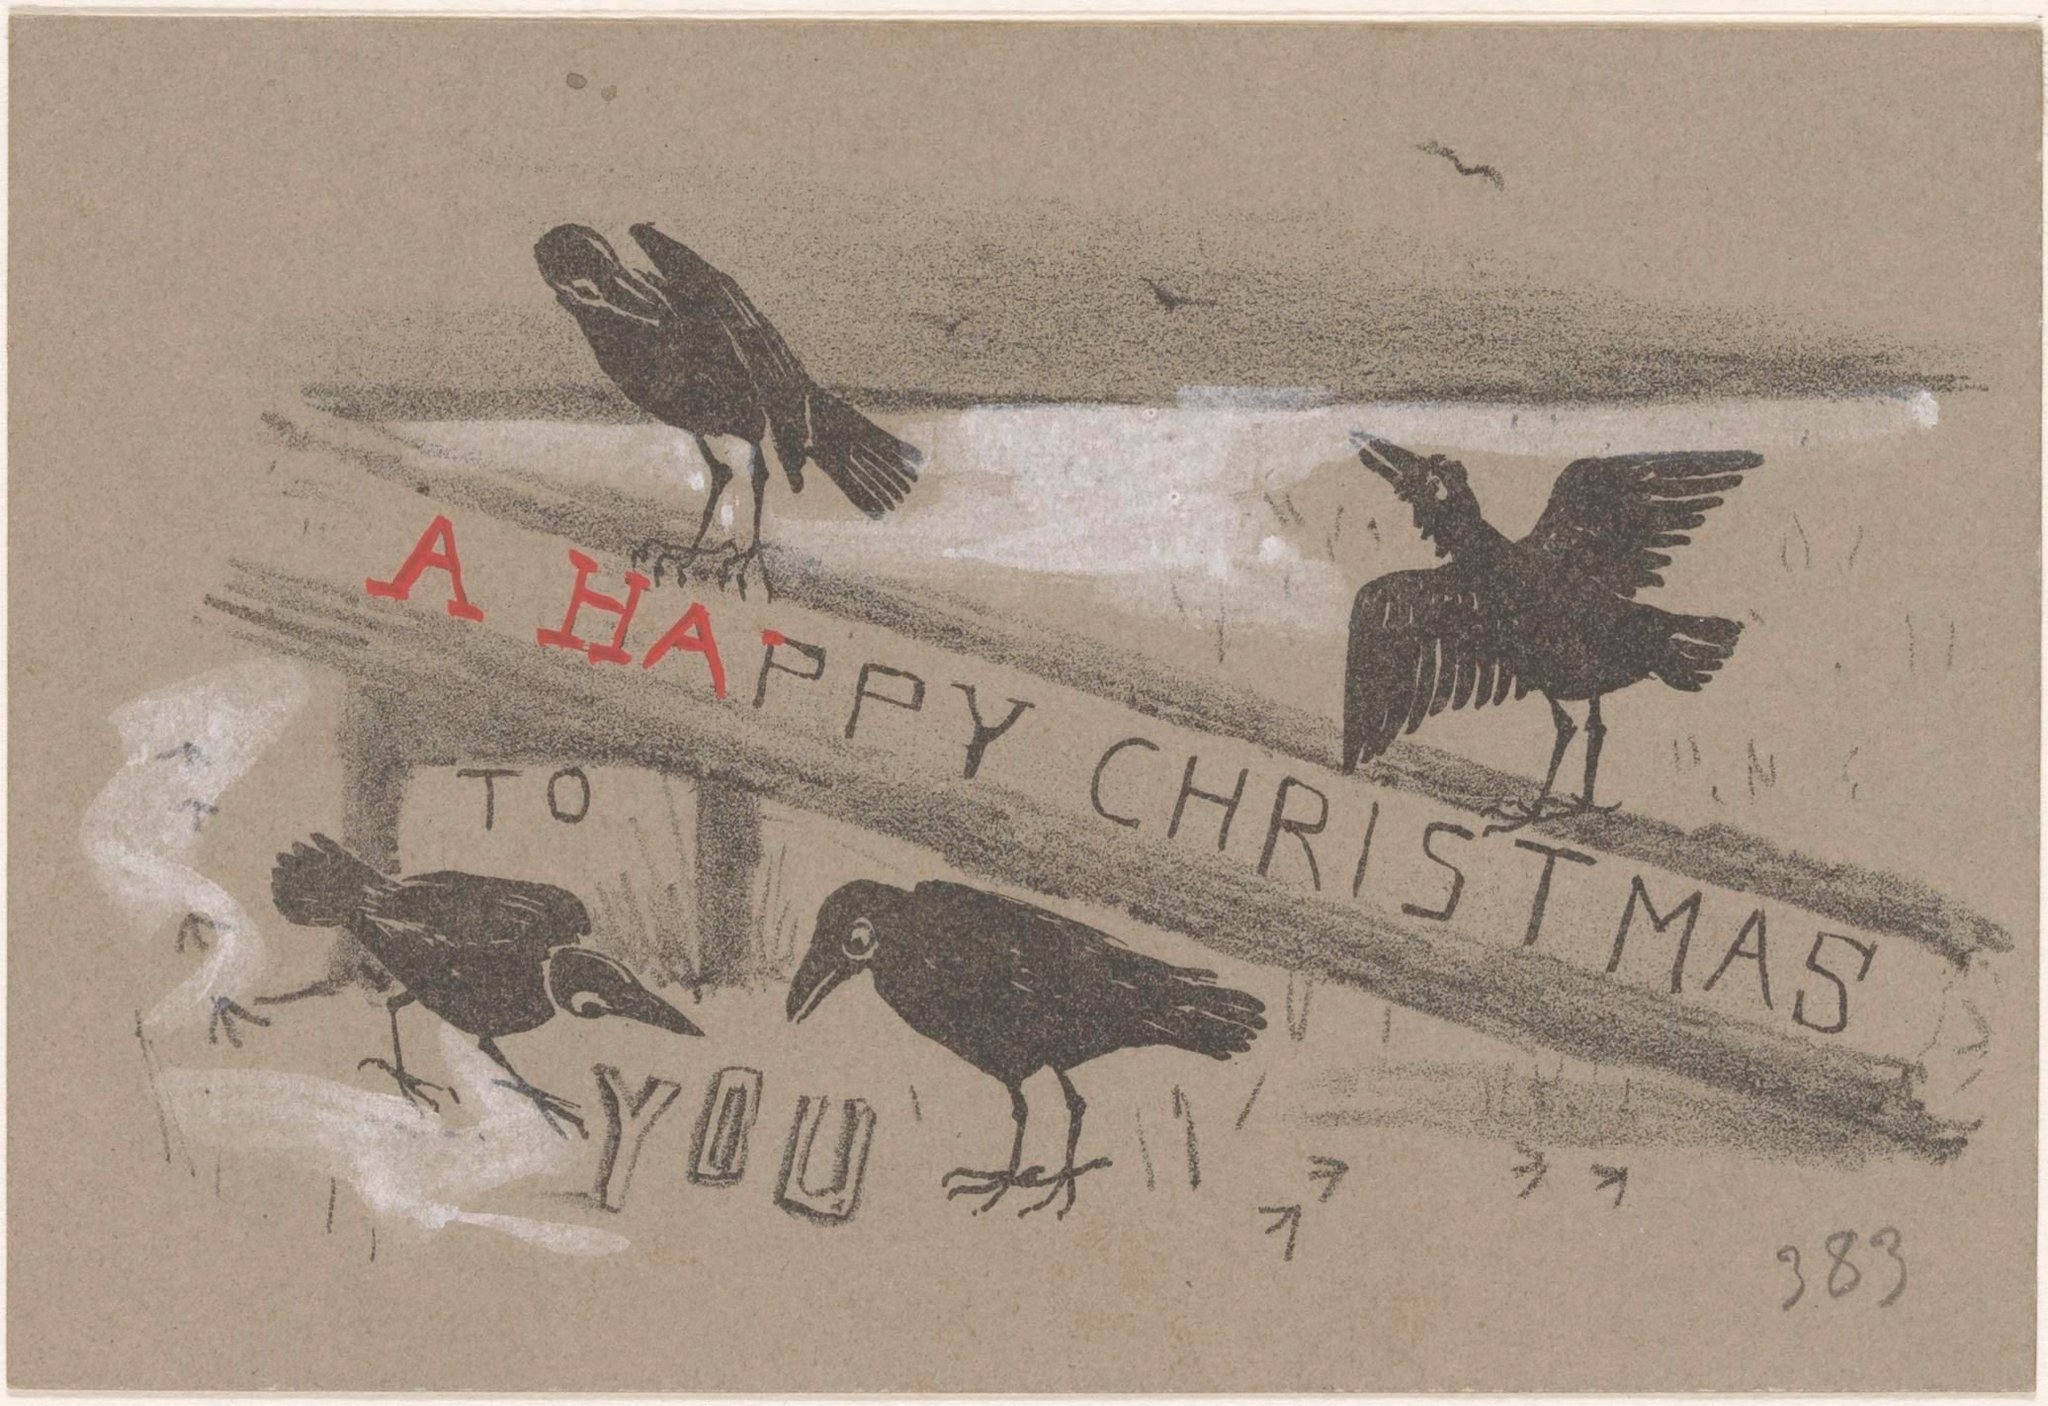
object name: christmas card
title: Kerstkaart met vier kraaien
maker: theo van hoytema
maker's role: draughtsman, painter, print maker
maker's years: 1863-1917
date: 1878-1917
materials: paper, watercolor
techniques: hand coloring, lithograph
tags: song-birds: crow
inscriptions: collector's mark: Lugt 2228, number: ‘383’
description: Vier kraaien bij een hek met de tekst 'A happy Christmas to you'.